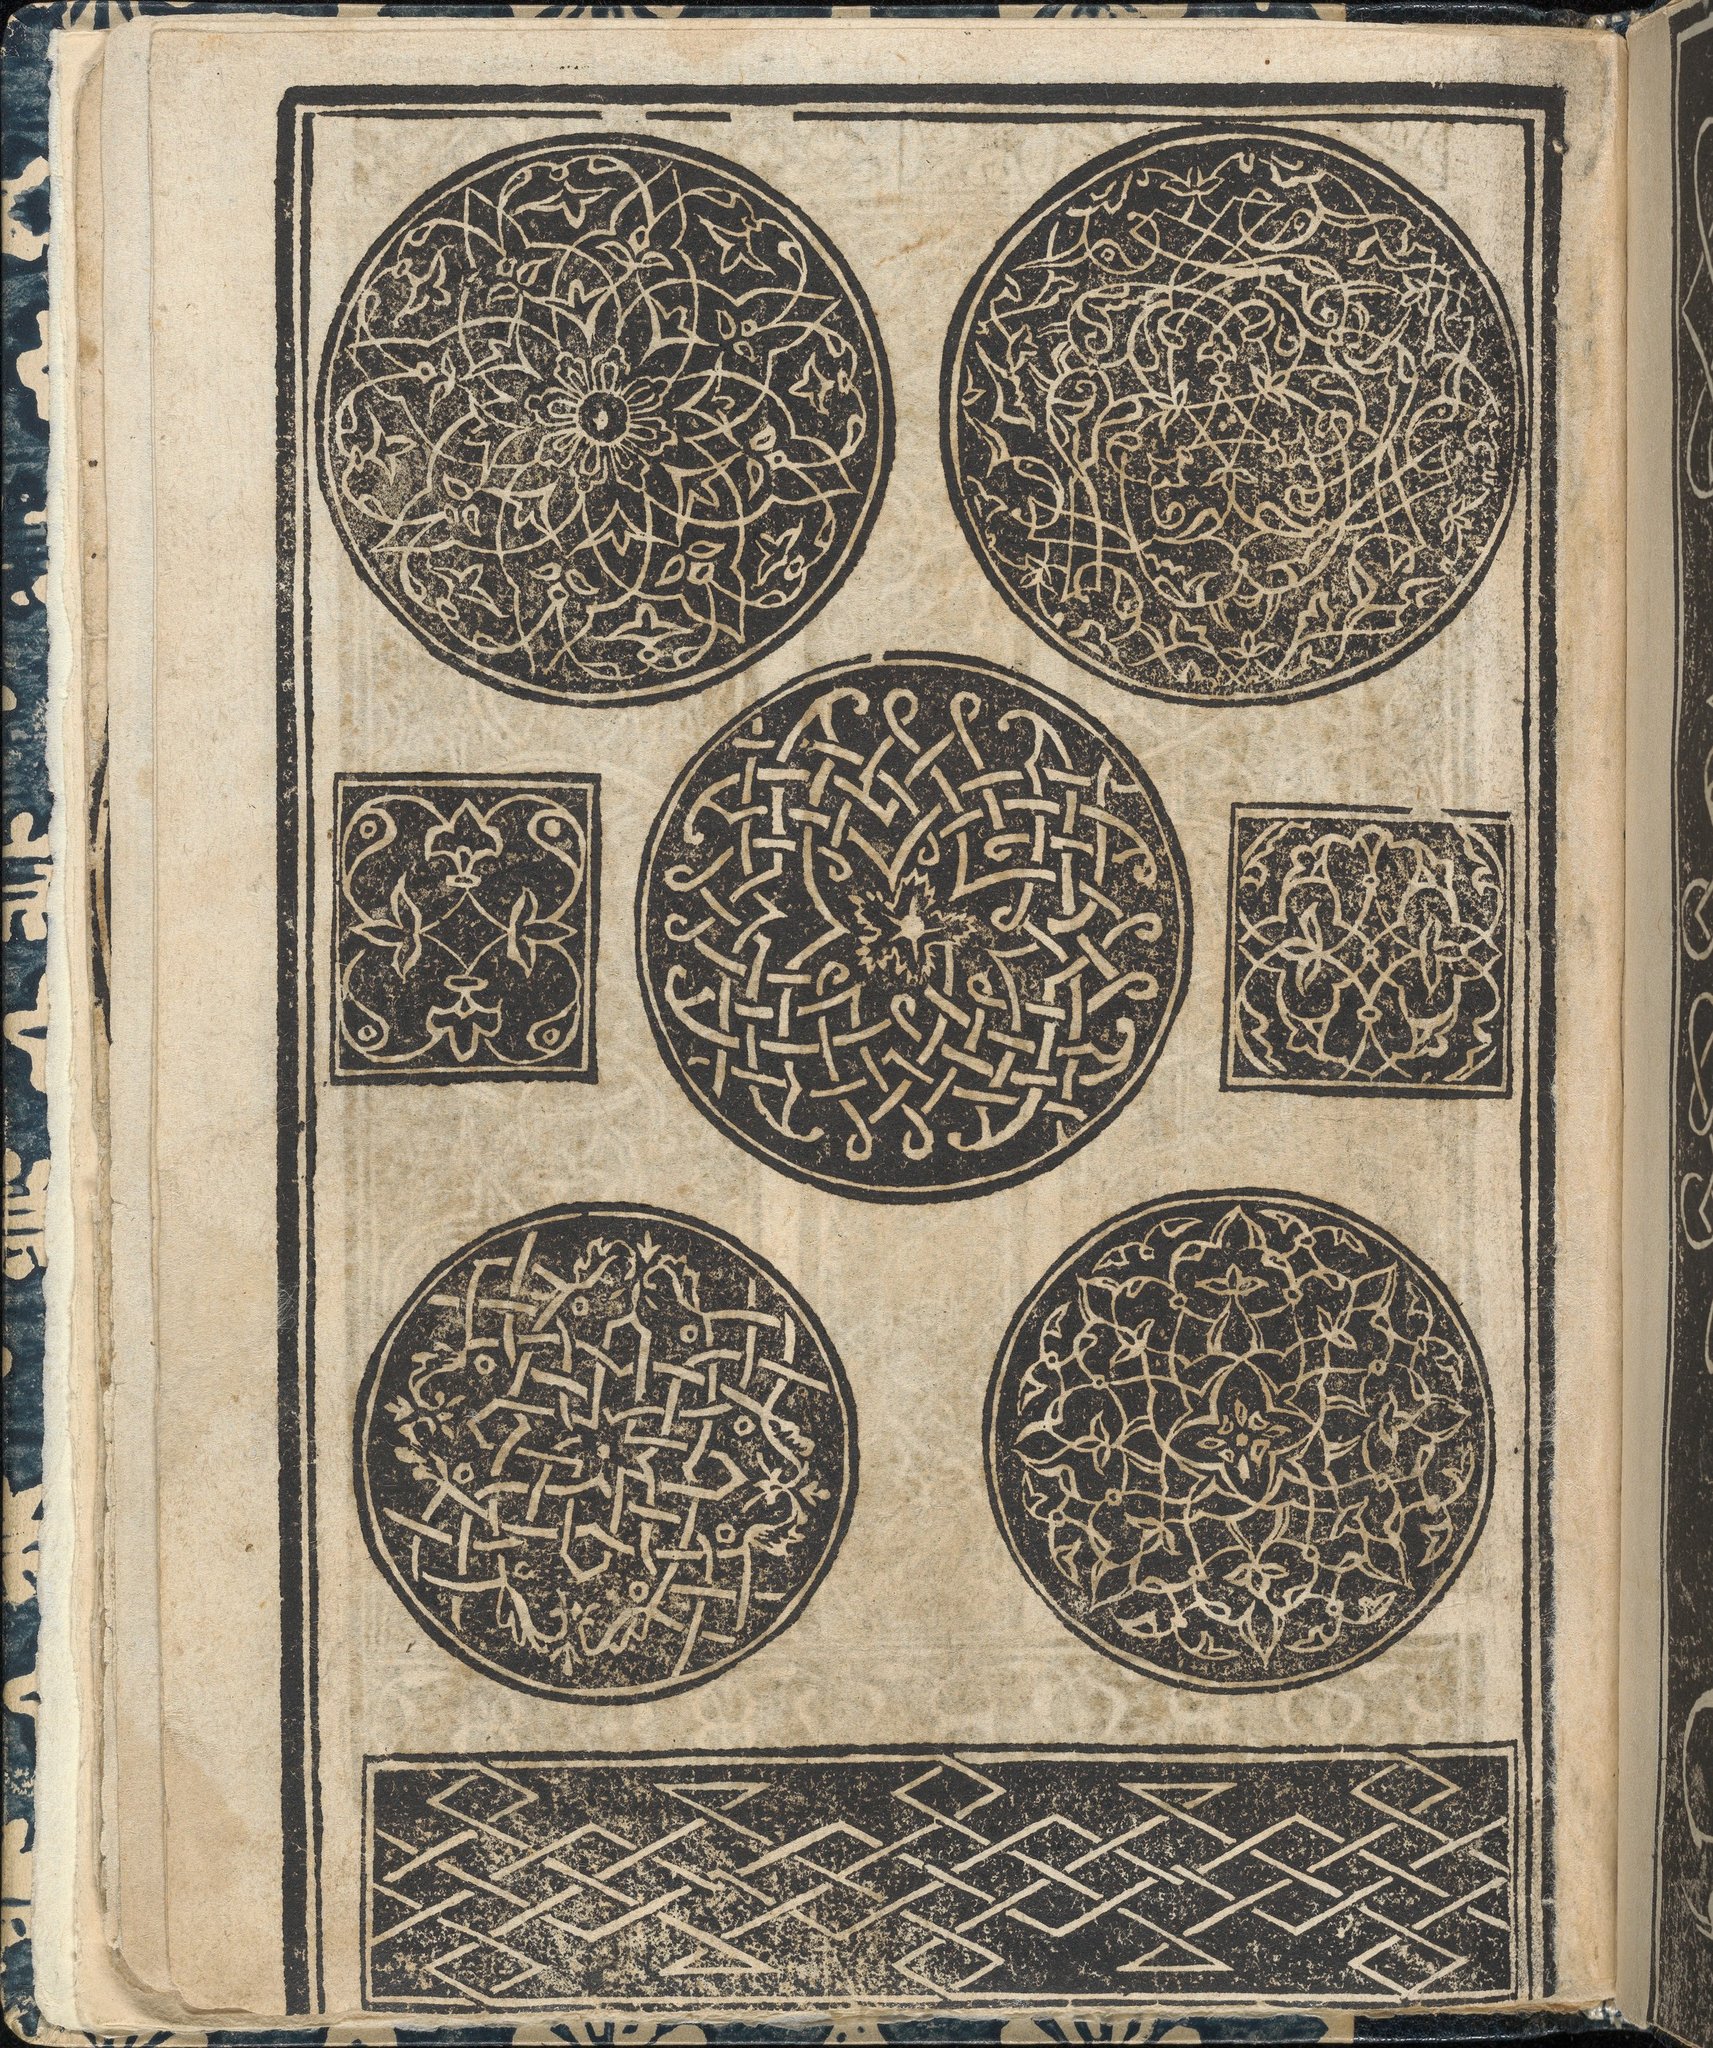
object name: book print ornament architecture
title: Essempio di recammi, page 16 (verso)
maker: giovanni antonio tagliente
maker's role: author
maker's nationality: italian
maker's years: 1465-1528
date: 1530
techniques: woodcut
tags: ornament